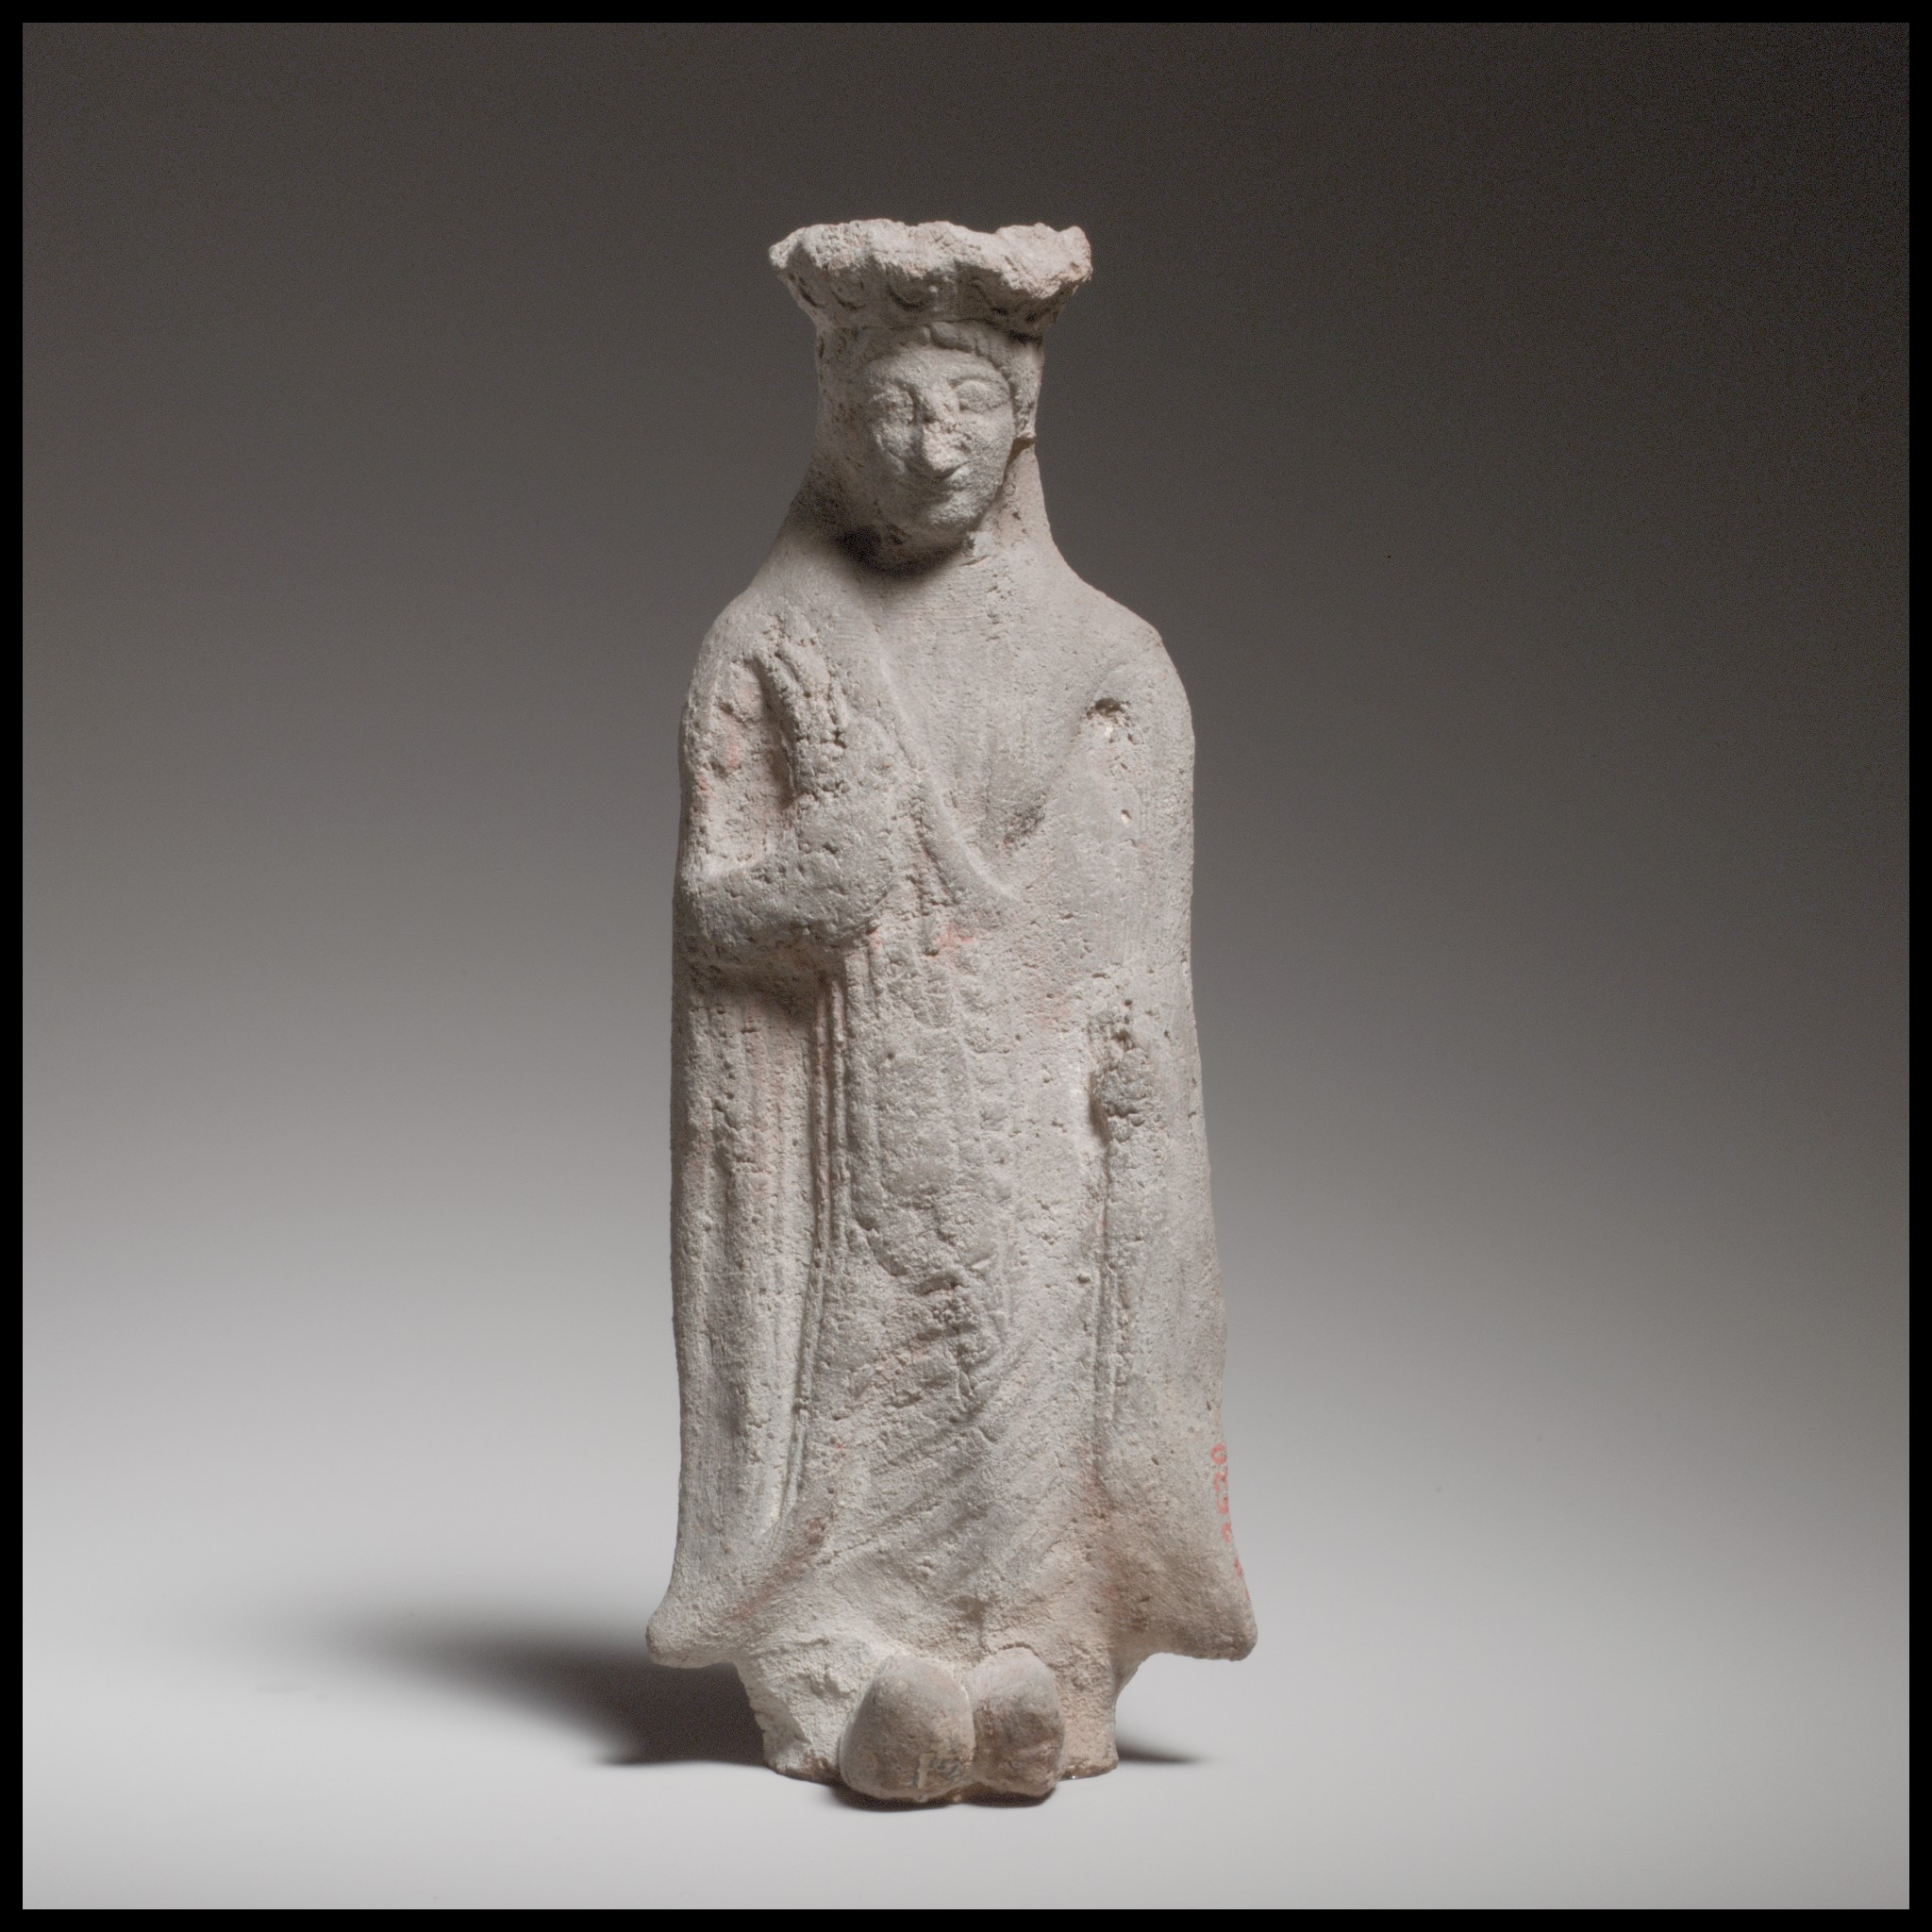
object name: statuette of a woman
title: Terracotta statuette of a standing woman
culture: cypriot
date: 500-468 BCE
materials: terracotta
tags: women